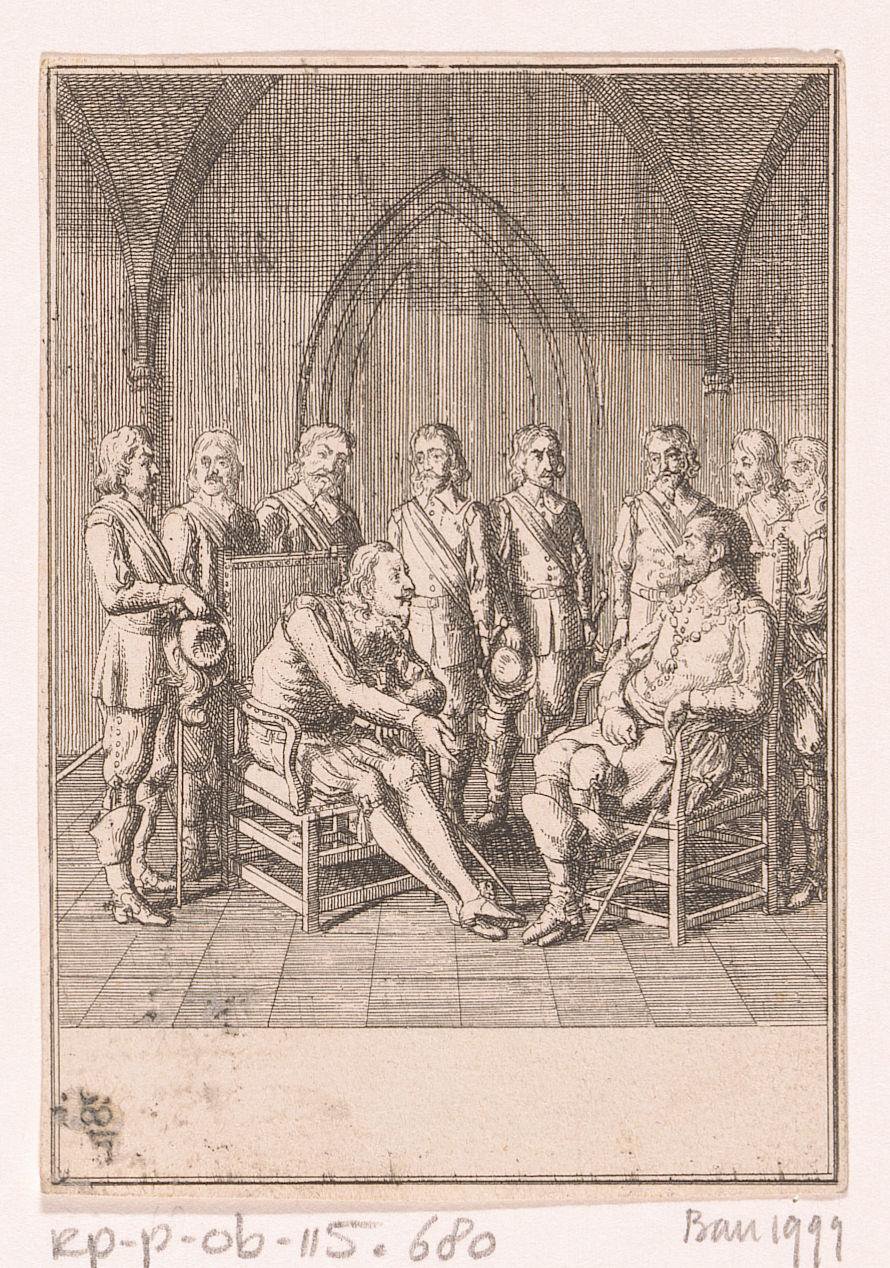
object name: print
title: Maximiliaan van Beieren in onderhandeling met Wallenstein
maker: daniel nikolaus chodowiecki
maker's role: draughtsman, print maker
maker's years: 1726-1801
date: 1799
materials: paper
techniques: etching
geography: berlin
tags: maximiliaan i (keurvorst van beieren), meeting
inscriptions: collector's mark: Lugt 2228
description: Prent gebruikt voor: Woltmann, Karl Ludwig von. Historischer Kalender auf das Gemein-Jahr 1803 (...). Berlijn: Johann Friedrich Unger, s.a.